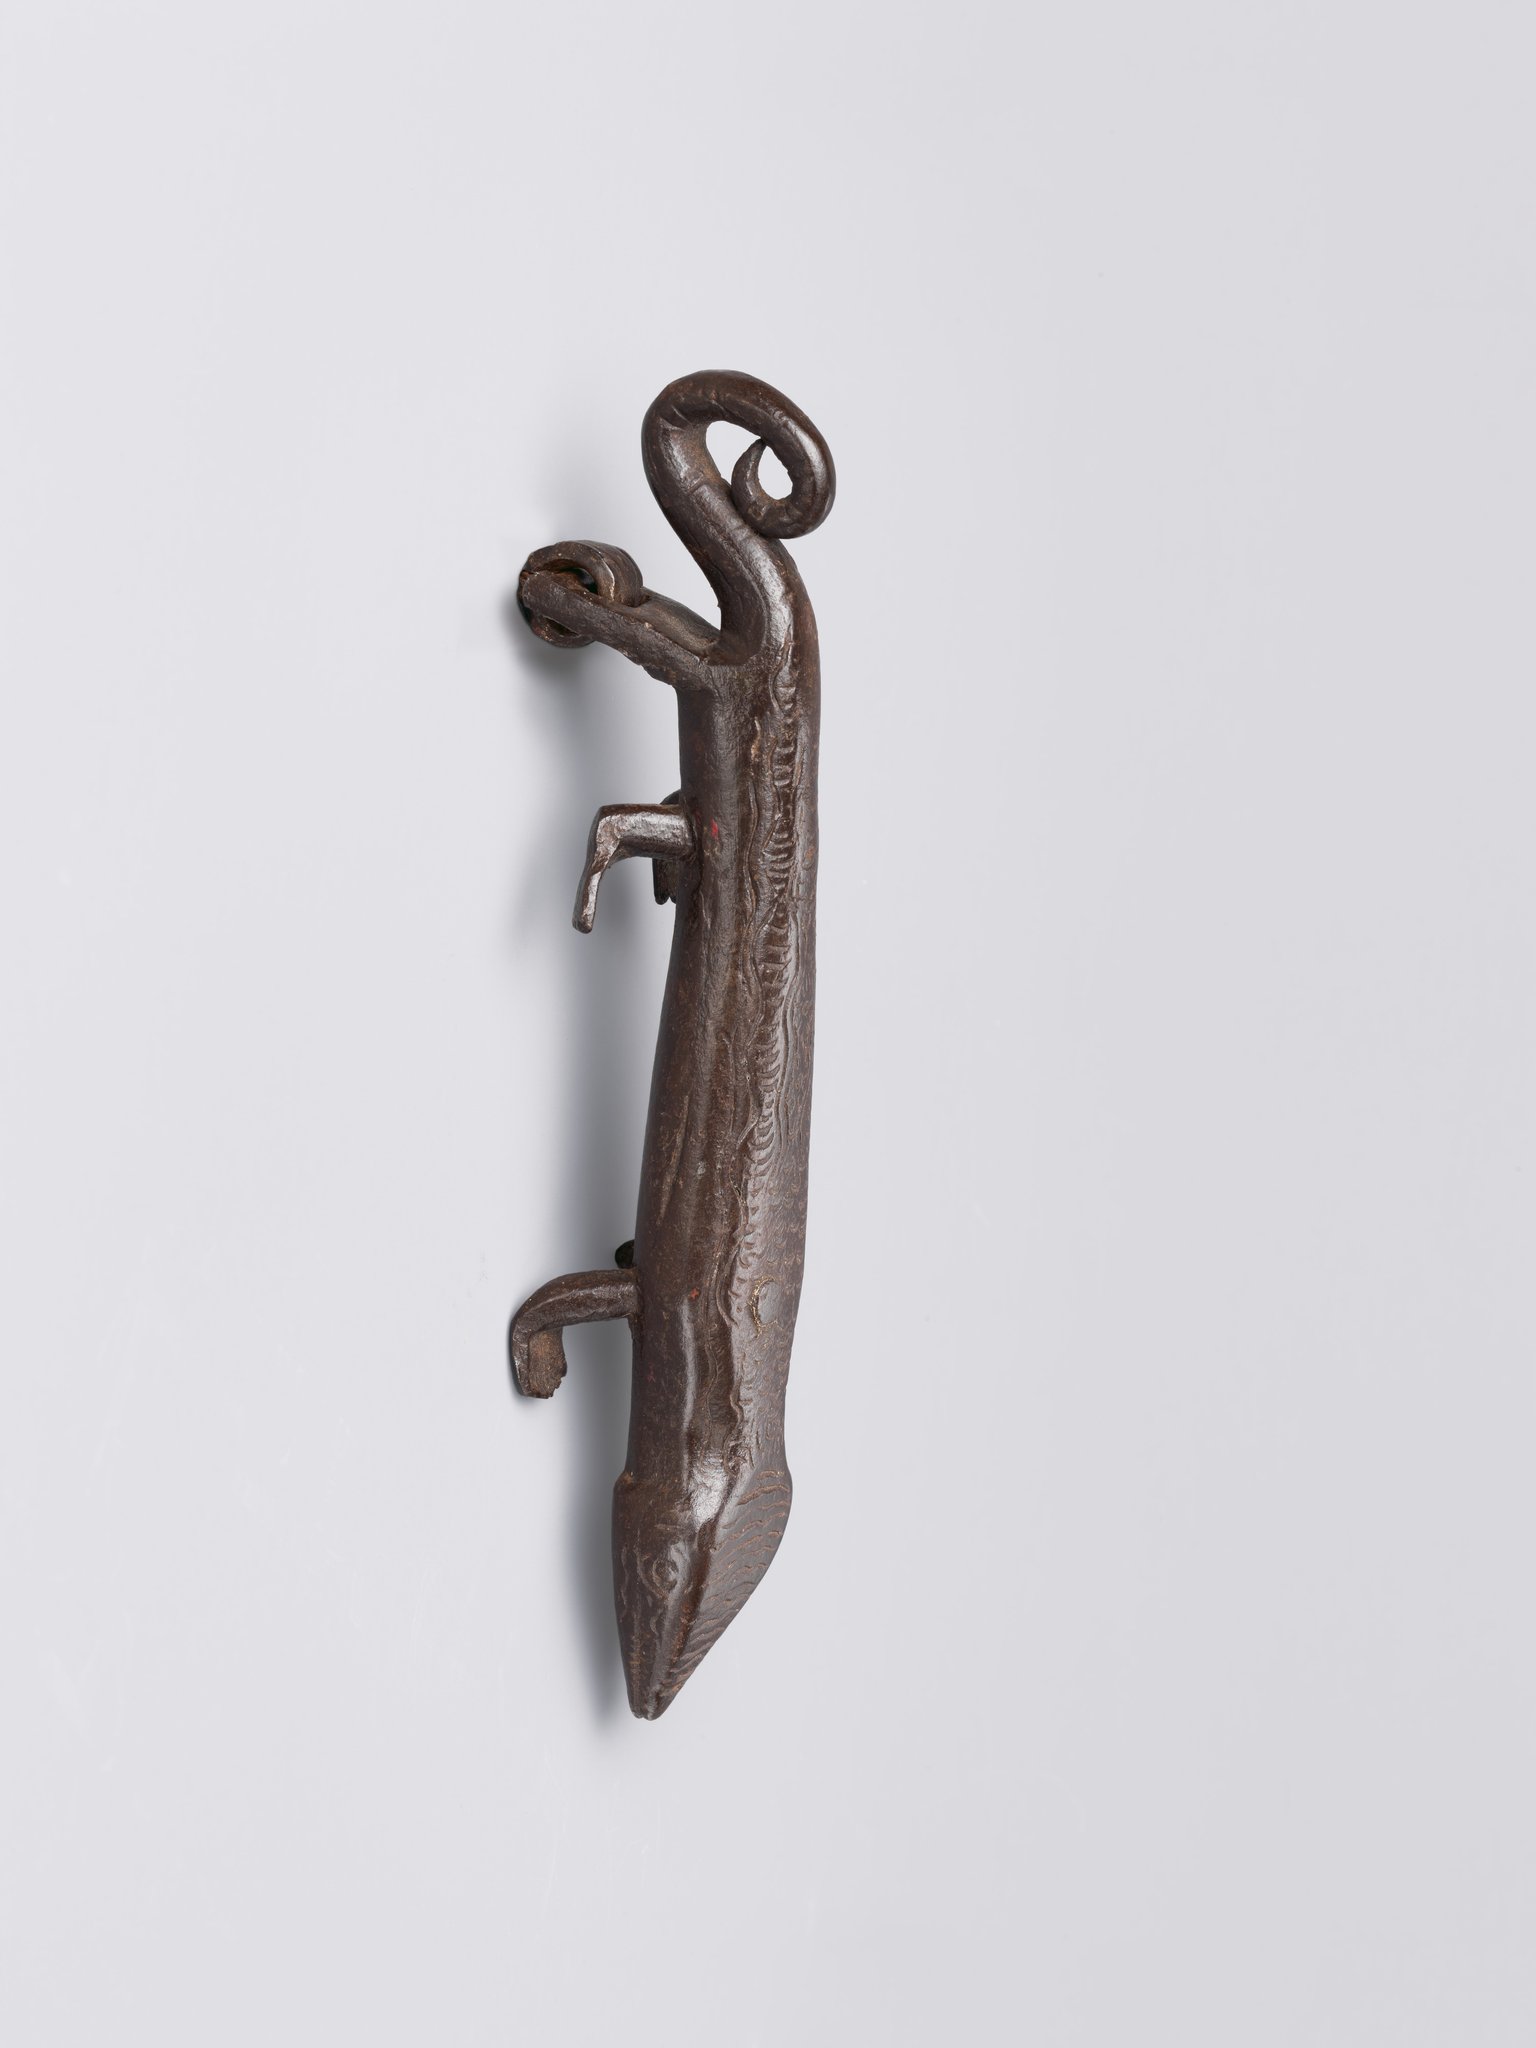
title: Door knocker in the shape of a salamander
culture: spanish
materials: iron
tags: salamanders